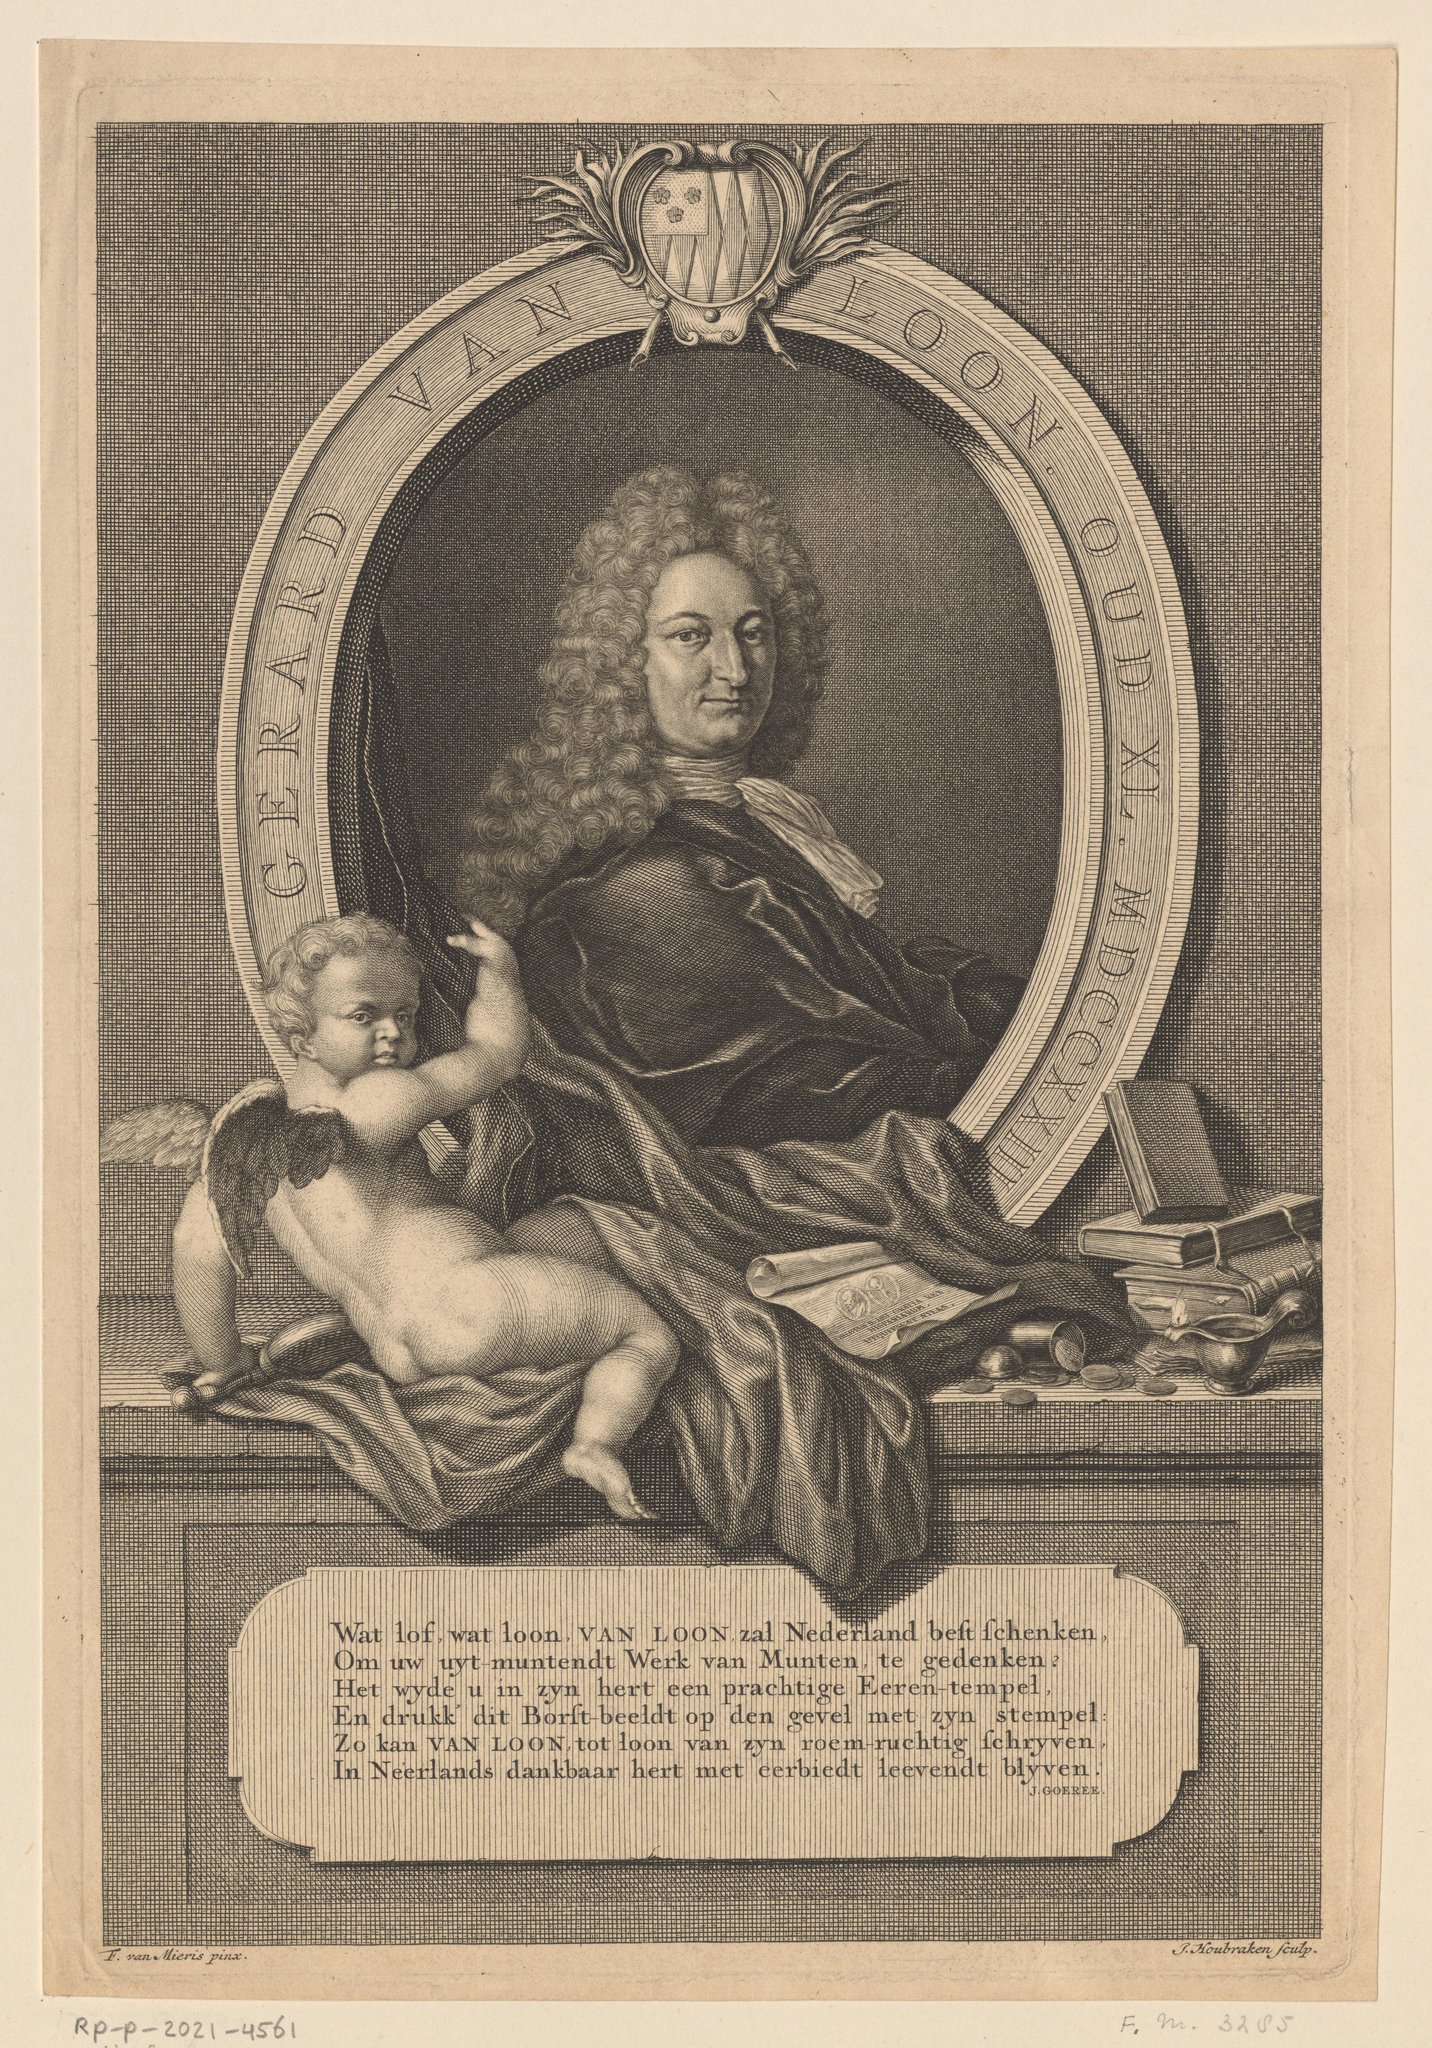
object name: print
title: Portret van Gerard van Loon op 40-jarige leeftijd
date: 1723-1732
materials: paper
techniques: engraving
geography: amsterdam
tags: designer, gerard van loon, (feigned) picture curtain, ornament ~ medallion, historical persons, medal (considered as a piece of sculpture, regardless of its specific function), book, cupids: 'amores', 'amoretti', 'putti', armorial bearing, heraldry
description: Portret in medaillon. Het portret rust op een sokkel met daarop een cartouche met een zesregelig lofdicht in het Nederlands. Links op de sokkel naast het portret een putto die gordijn openhoudt en rechts boeken, een olielamp en munten.